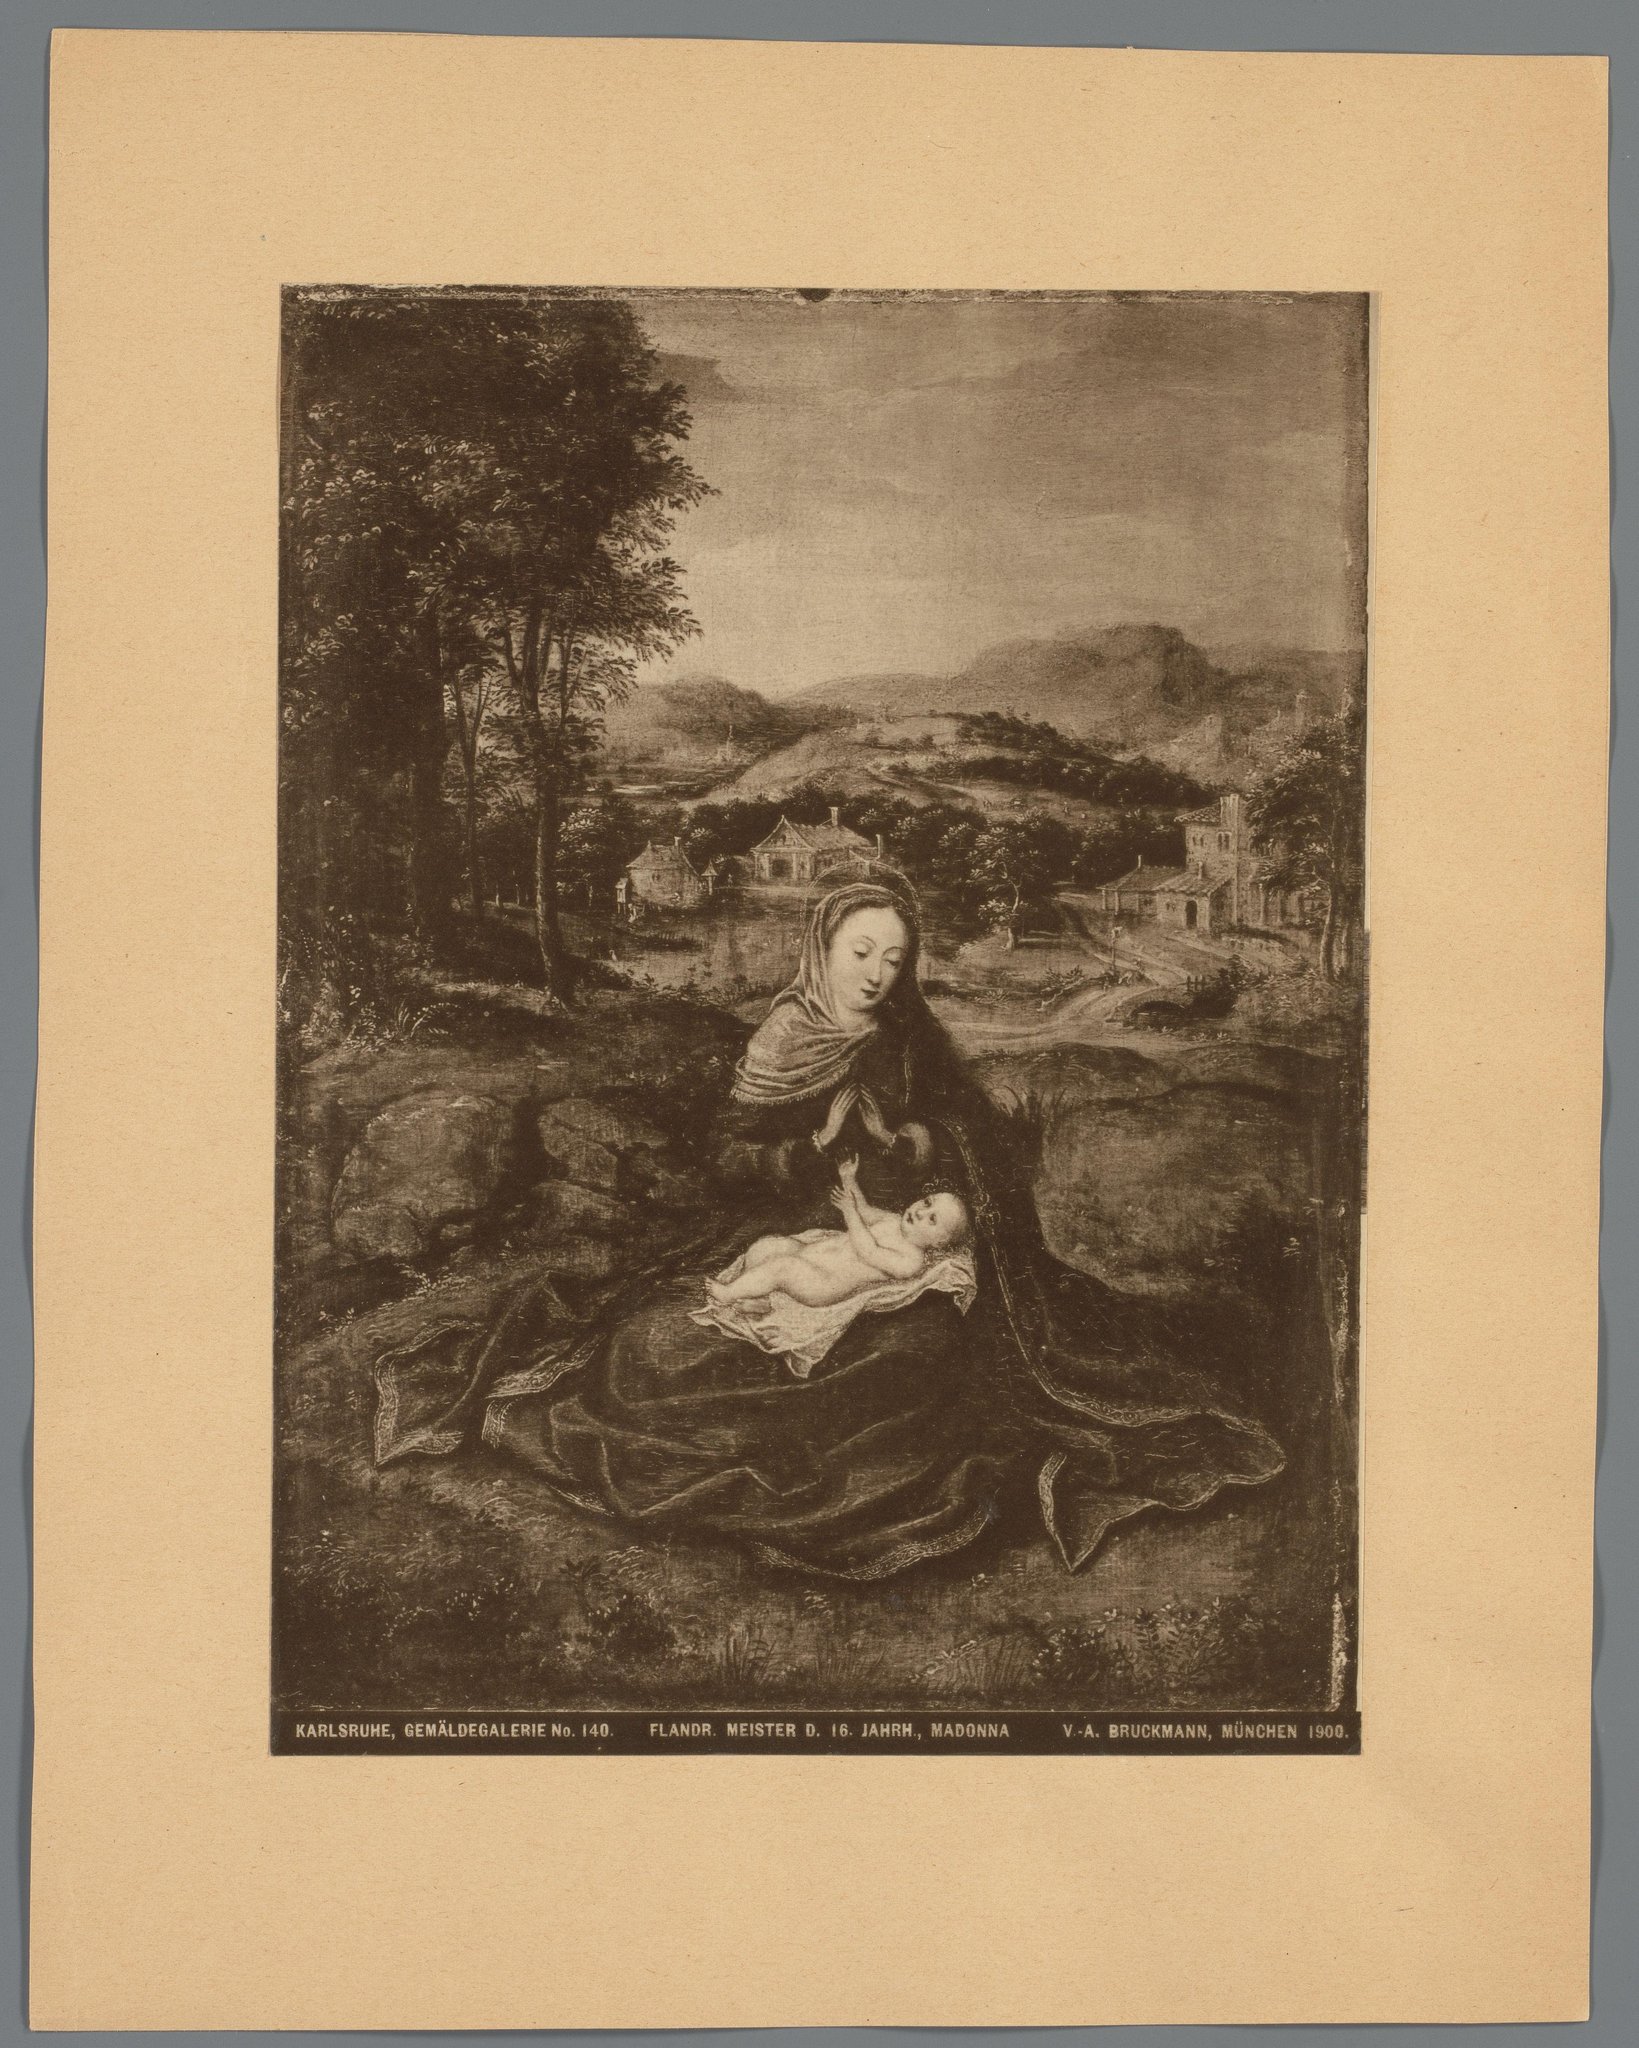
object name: reproduction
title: Madonna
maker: Anonymous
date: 1900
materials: paper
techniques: photograph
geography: munich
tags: low hill country, madonna: mary sitting on the ground, the christ-child in her lap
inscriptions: inscription: ‘Karlsruhe, Gemäldegalerie No. 140. Flandr. Meister d. 16. Jahrh.,’